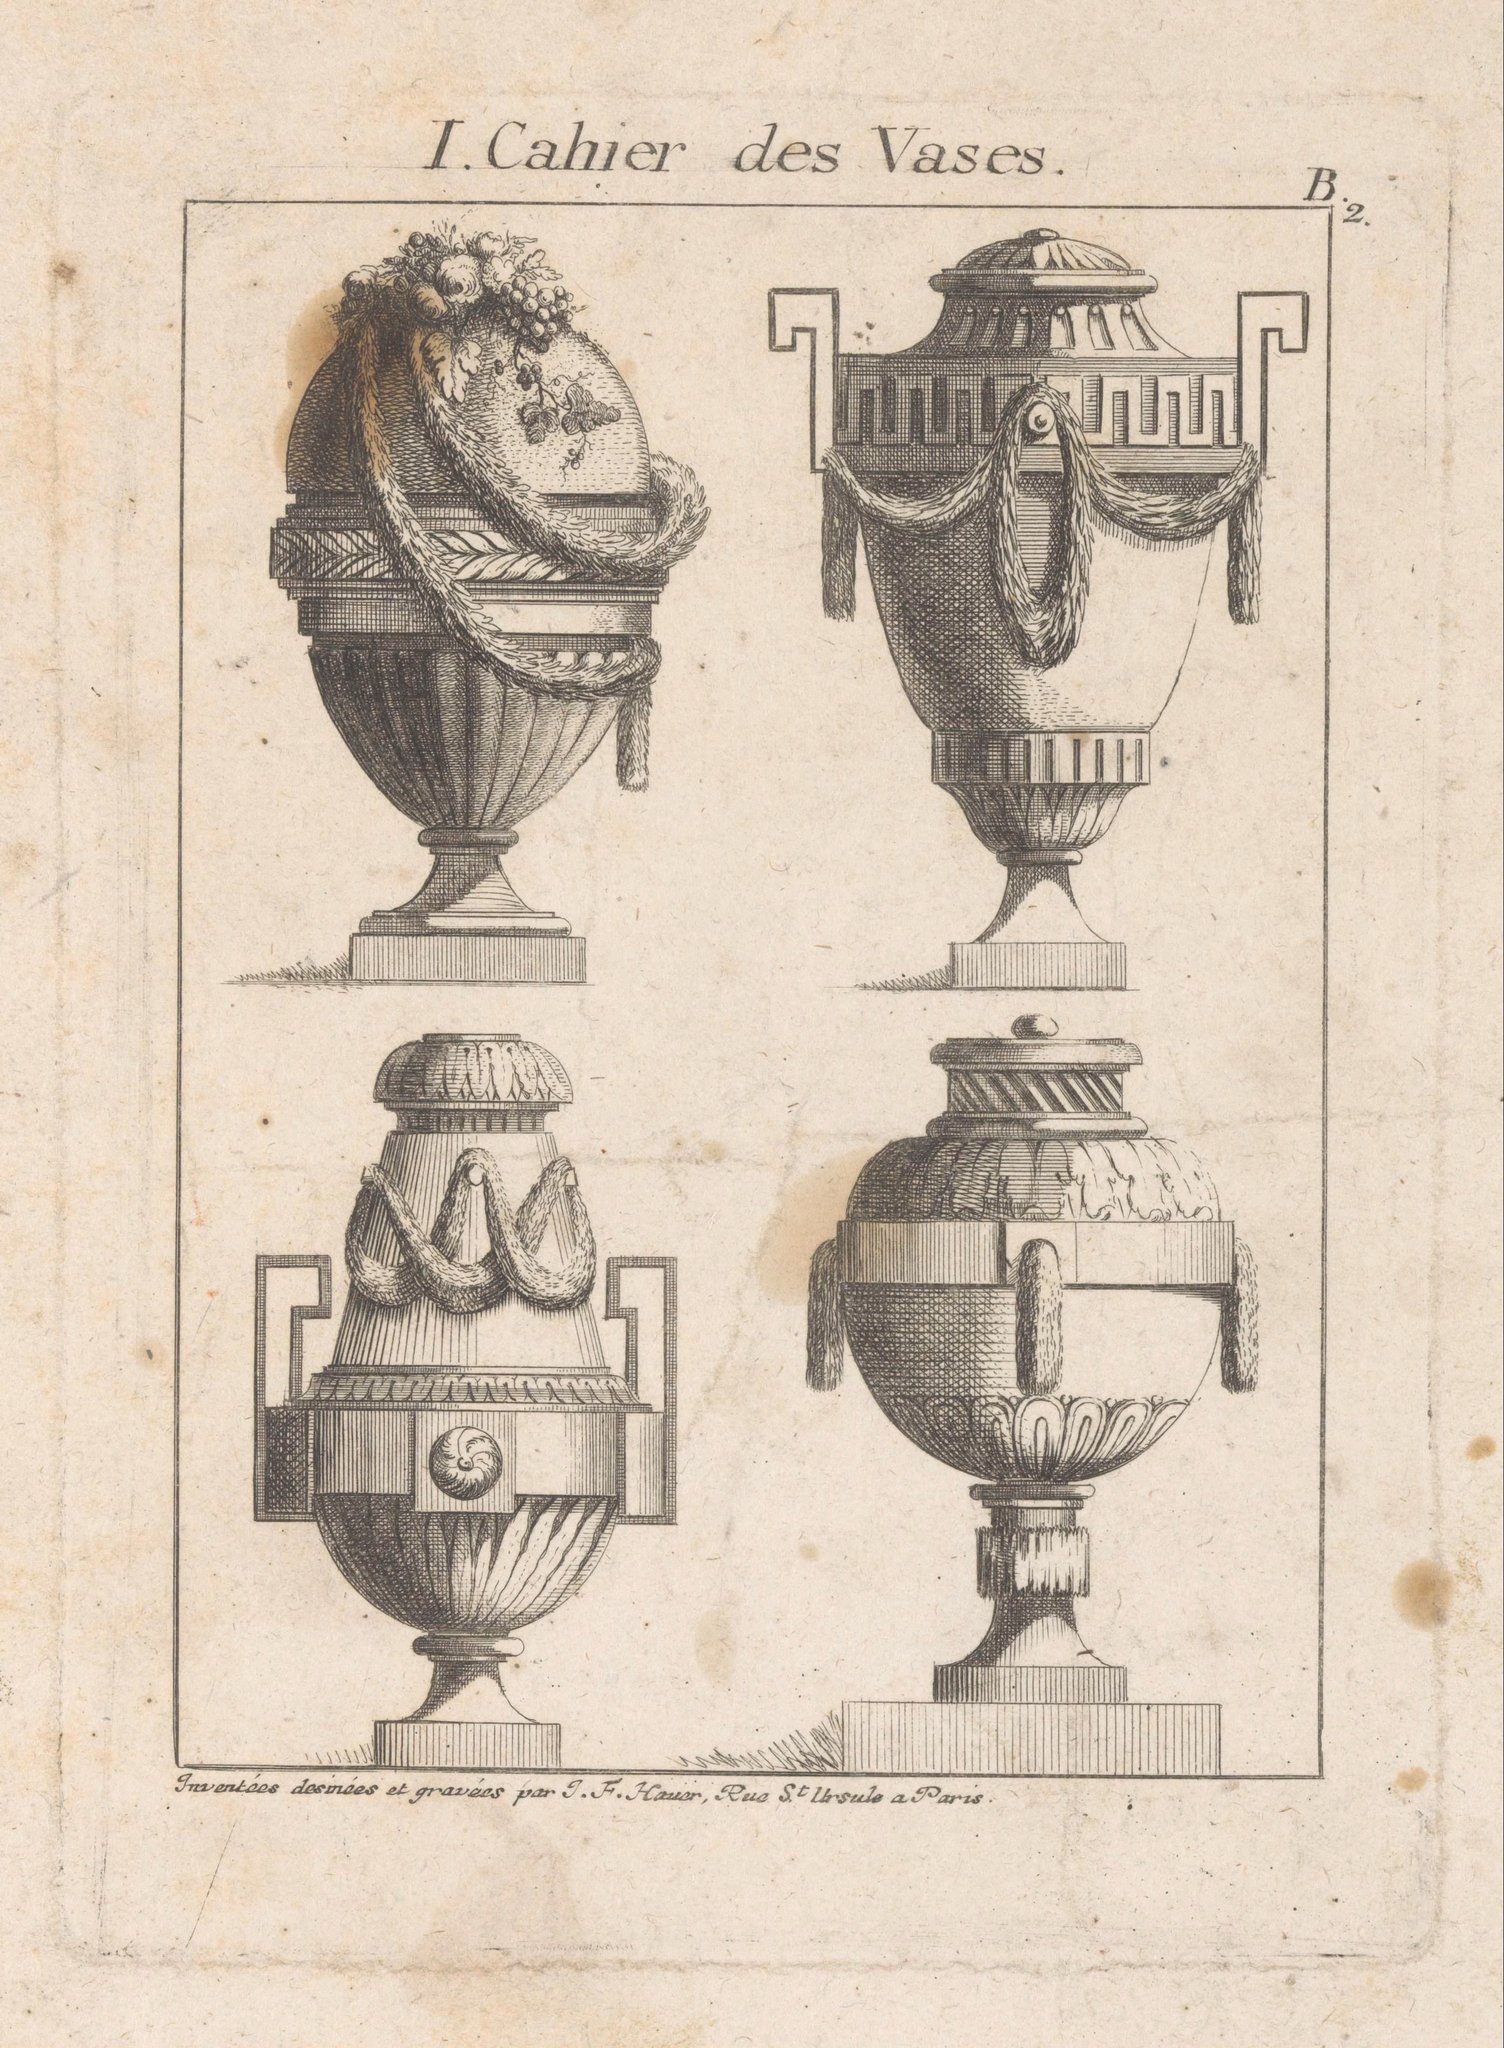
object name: ornament print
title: Vier vazen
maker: johann thomas hauer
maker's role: print maker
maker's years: 1748-1820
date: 1781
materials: paper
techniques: engraving, etching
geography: paris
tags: vase ~ ornament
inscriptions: collector's mark: Lugt 2228, collector's mark: Lugt 2760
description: Ontwerpen voor vier vazen met bloemen, guirlandes en ornamenten. De vazen rechts boven en links onder hebben twee oren.